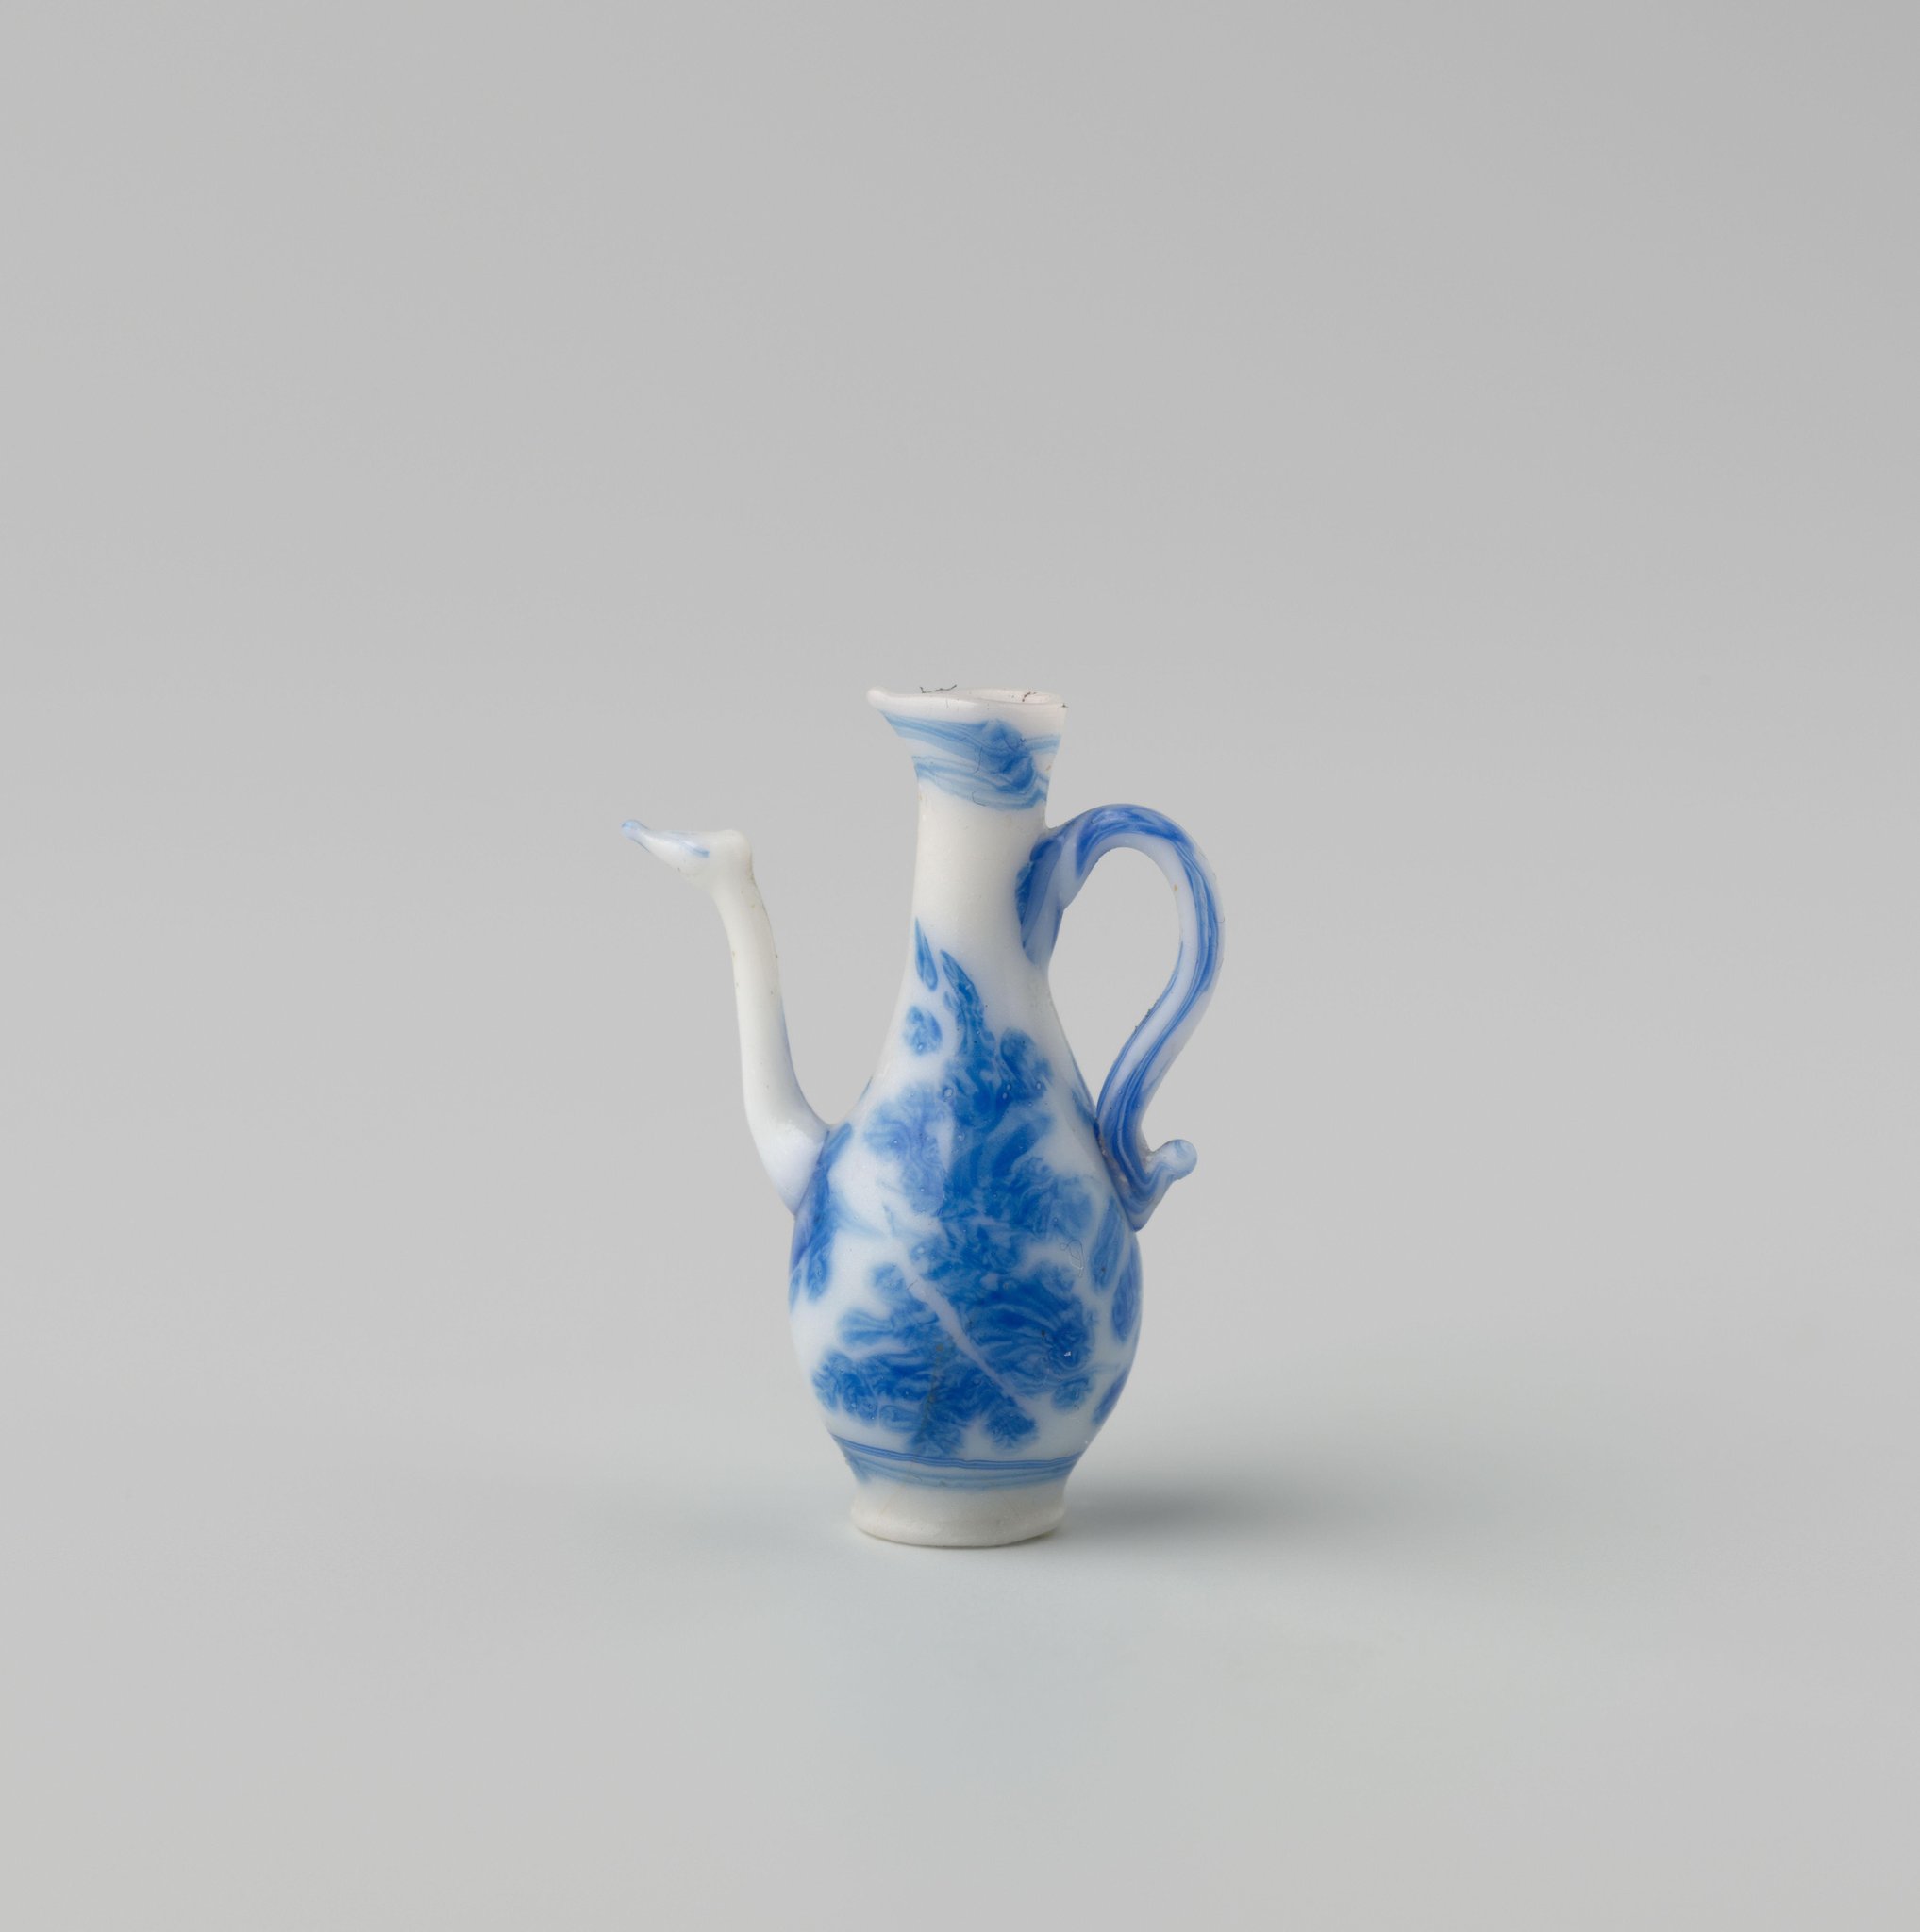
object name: ewer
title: Kan van melkglas met blauwe emailverf beschilderd, imitatie Chinees porselein; bloesemtakken op buik doorlopend op hals. Peervormig met handvat en tuit en een schenklip.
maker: Anonymous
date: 1675-1710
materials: glass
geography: amsterdam